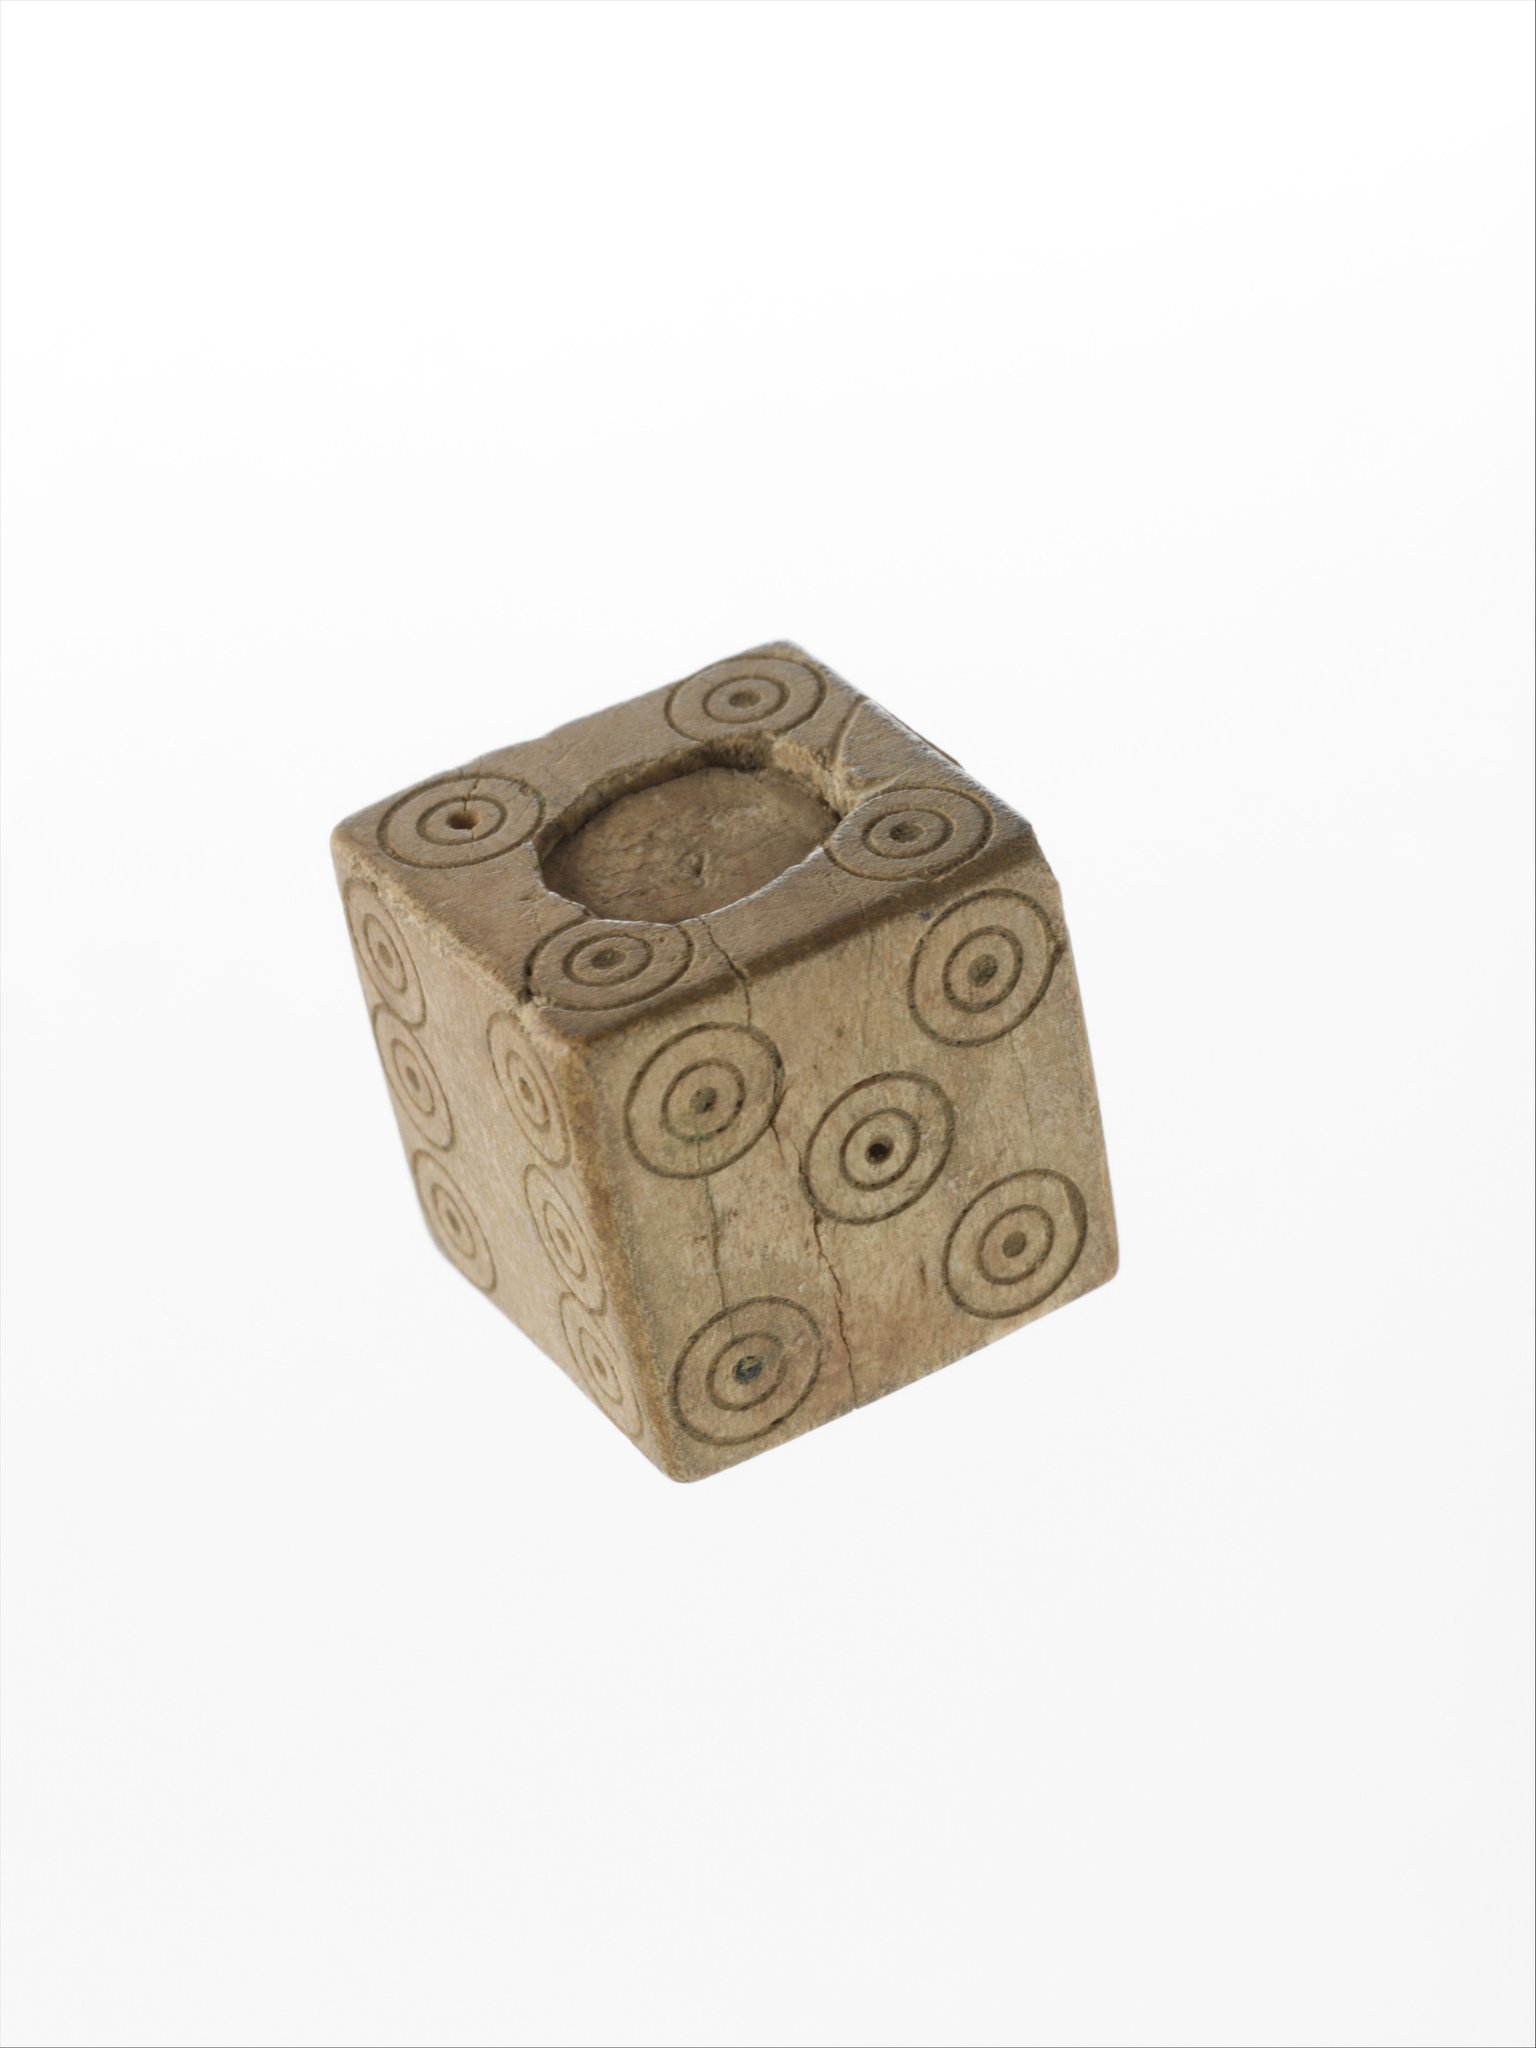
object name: die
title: Ivory die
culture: roman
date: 1-300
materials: ivory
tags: dice